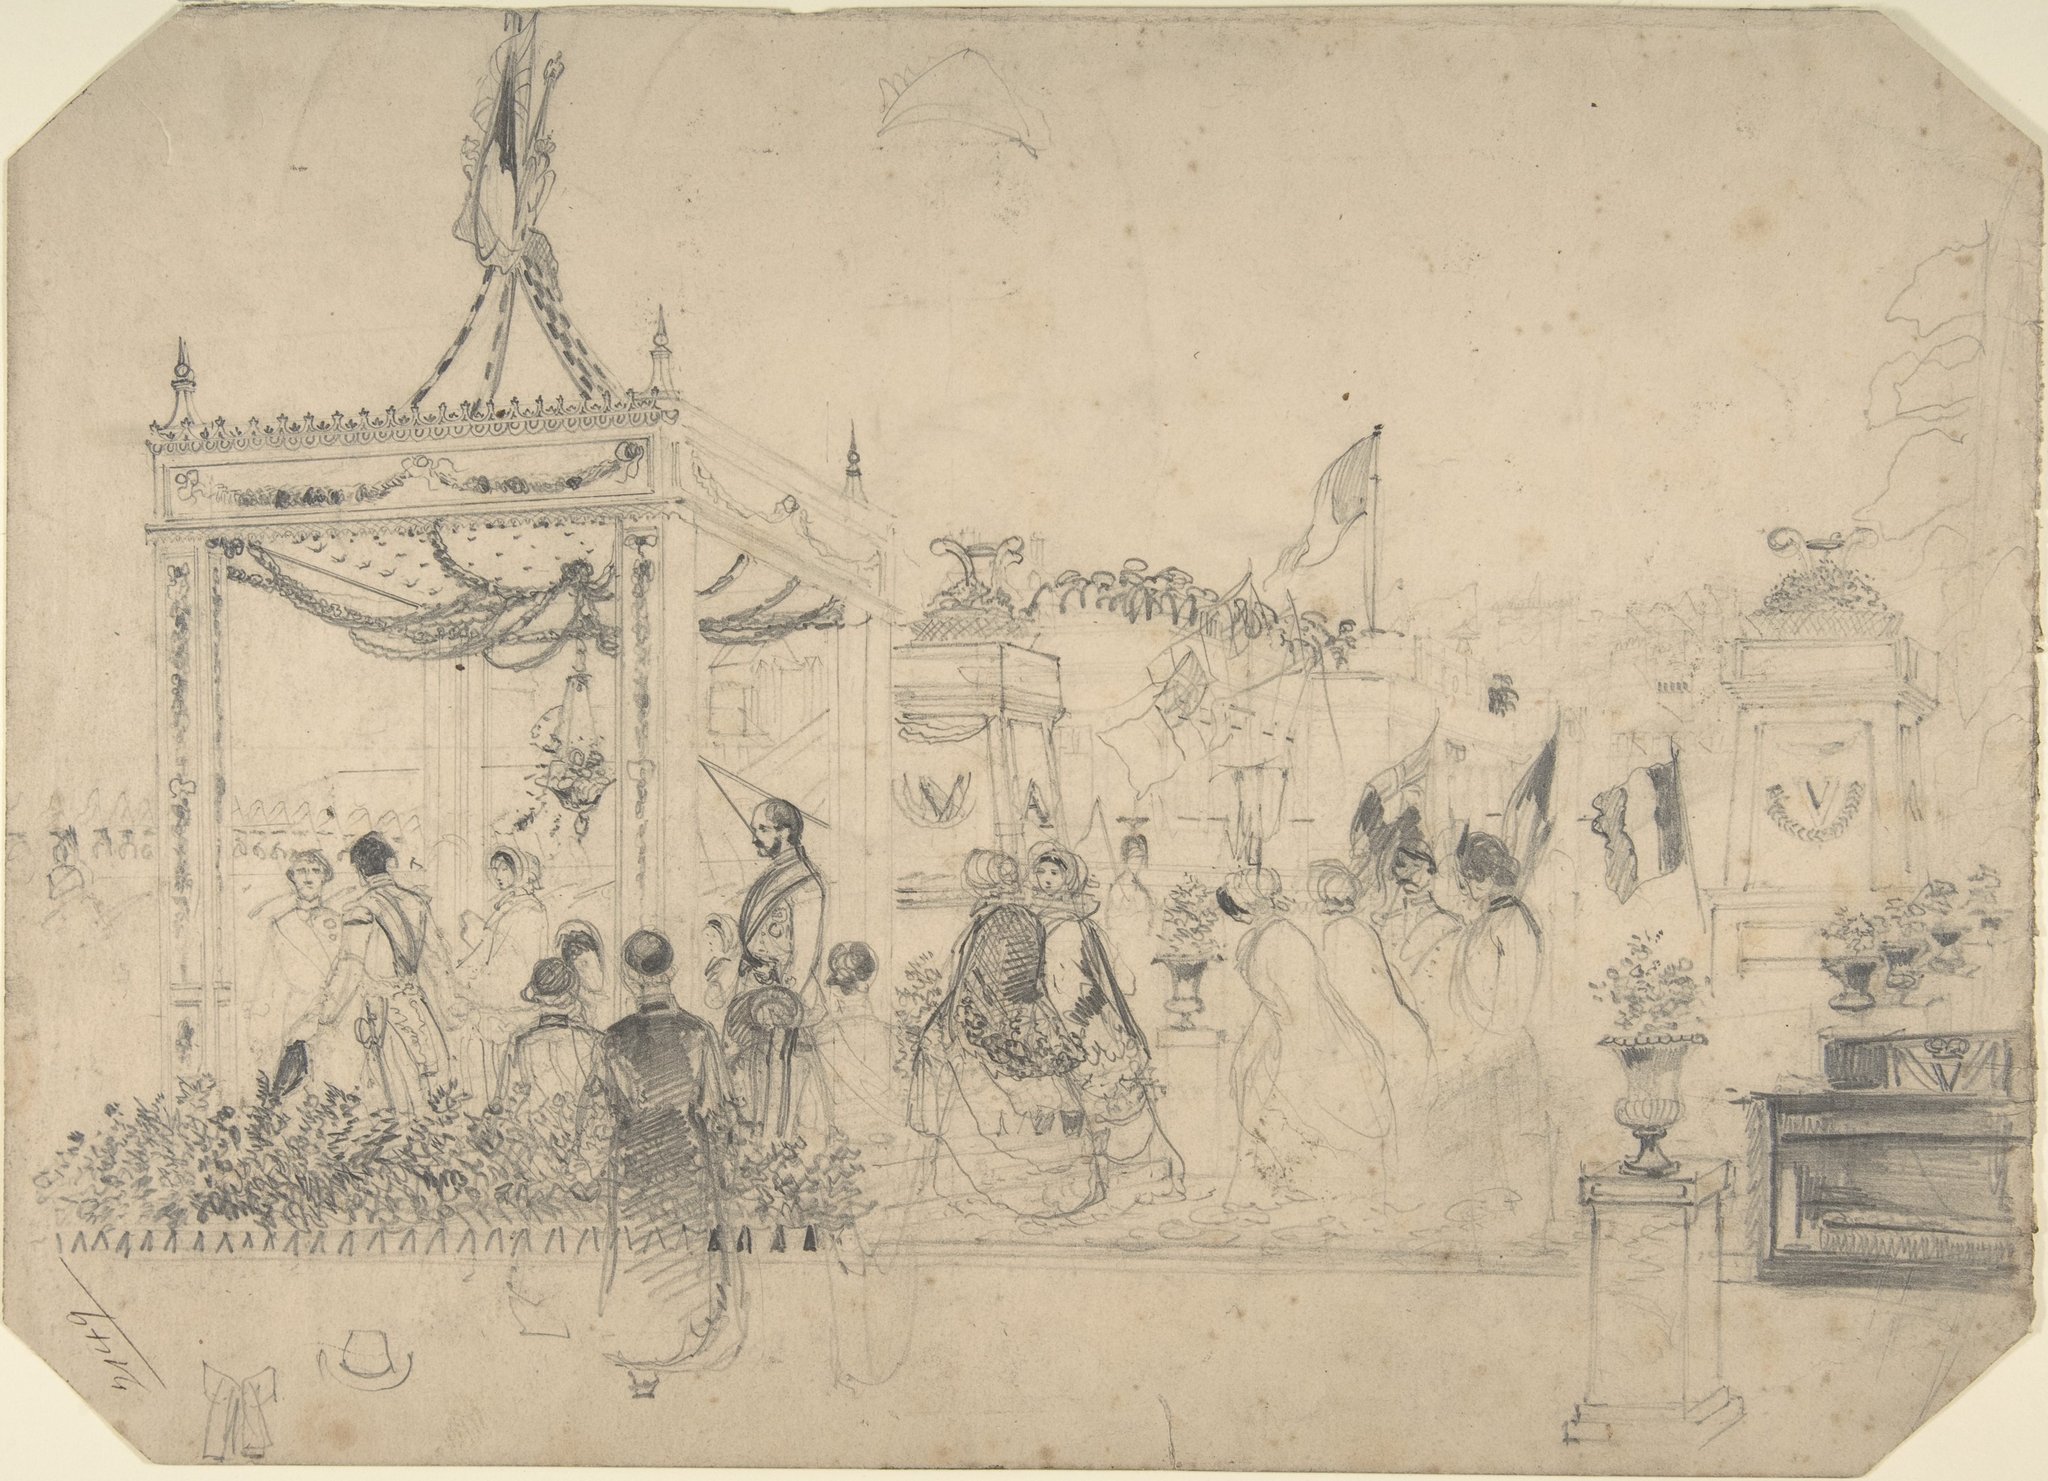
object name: drawing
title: Victoria and Albert Arriving in France for a State Visit (recto); Welcome Arch (verso)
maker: anonymous, british, 19th century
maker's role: artist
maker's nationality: british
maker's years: 1800-1900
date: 1855-1858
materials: graphite